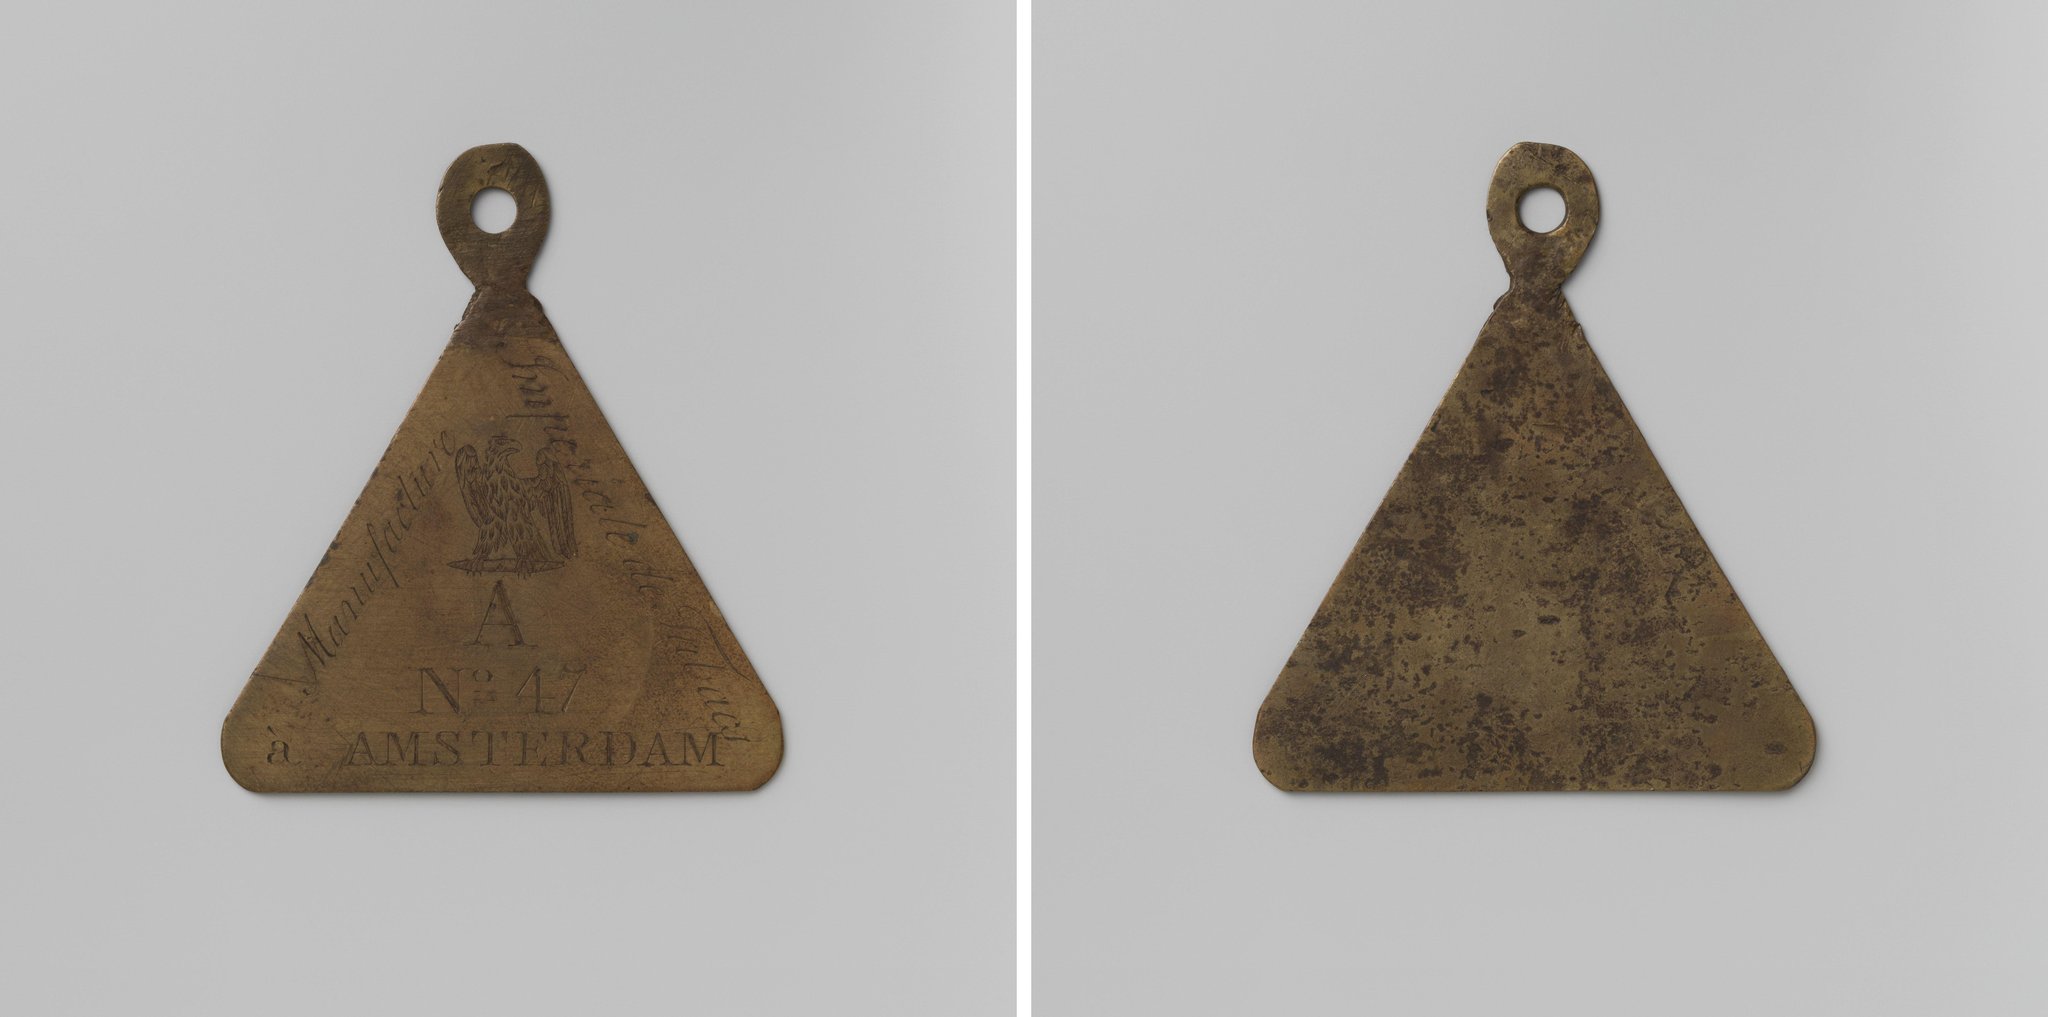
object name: insignia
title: Manufacture Imperiale de Tabacs te Amsterdam, draagteken, gedragen door een van de werknemers, met no. A 47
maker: Anonymous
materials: copper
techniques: engraving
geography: amsterdam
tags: amsterdam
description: Eenzijdig koperen driehoekig draagteken met afgeronde hoeken aan draagoog. Voorzijde: Franse adelaar boven letter A en opschrift No. 47 binnen omschrift. Keerzijde: blanco.